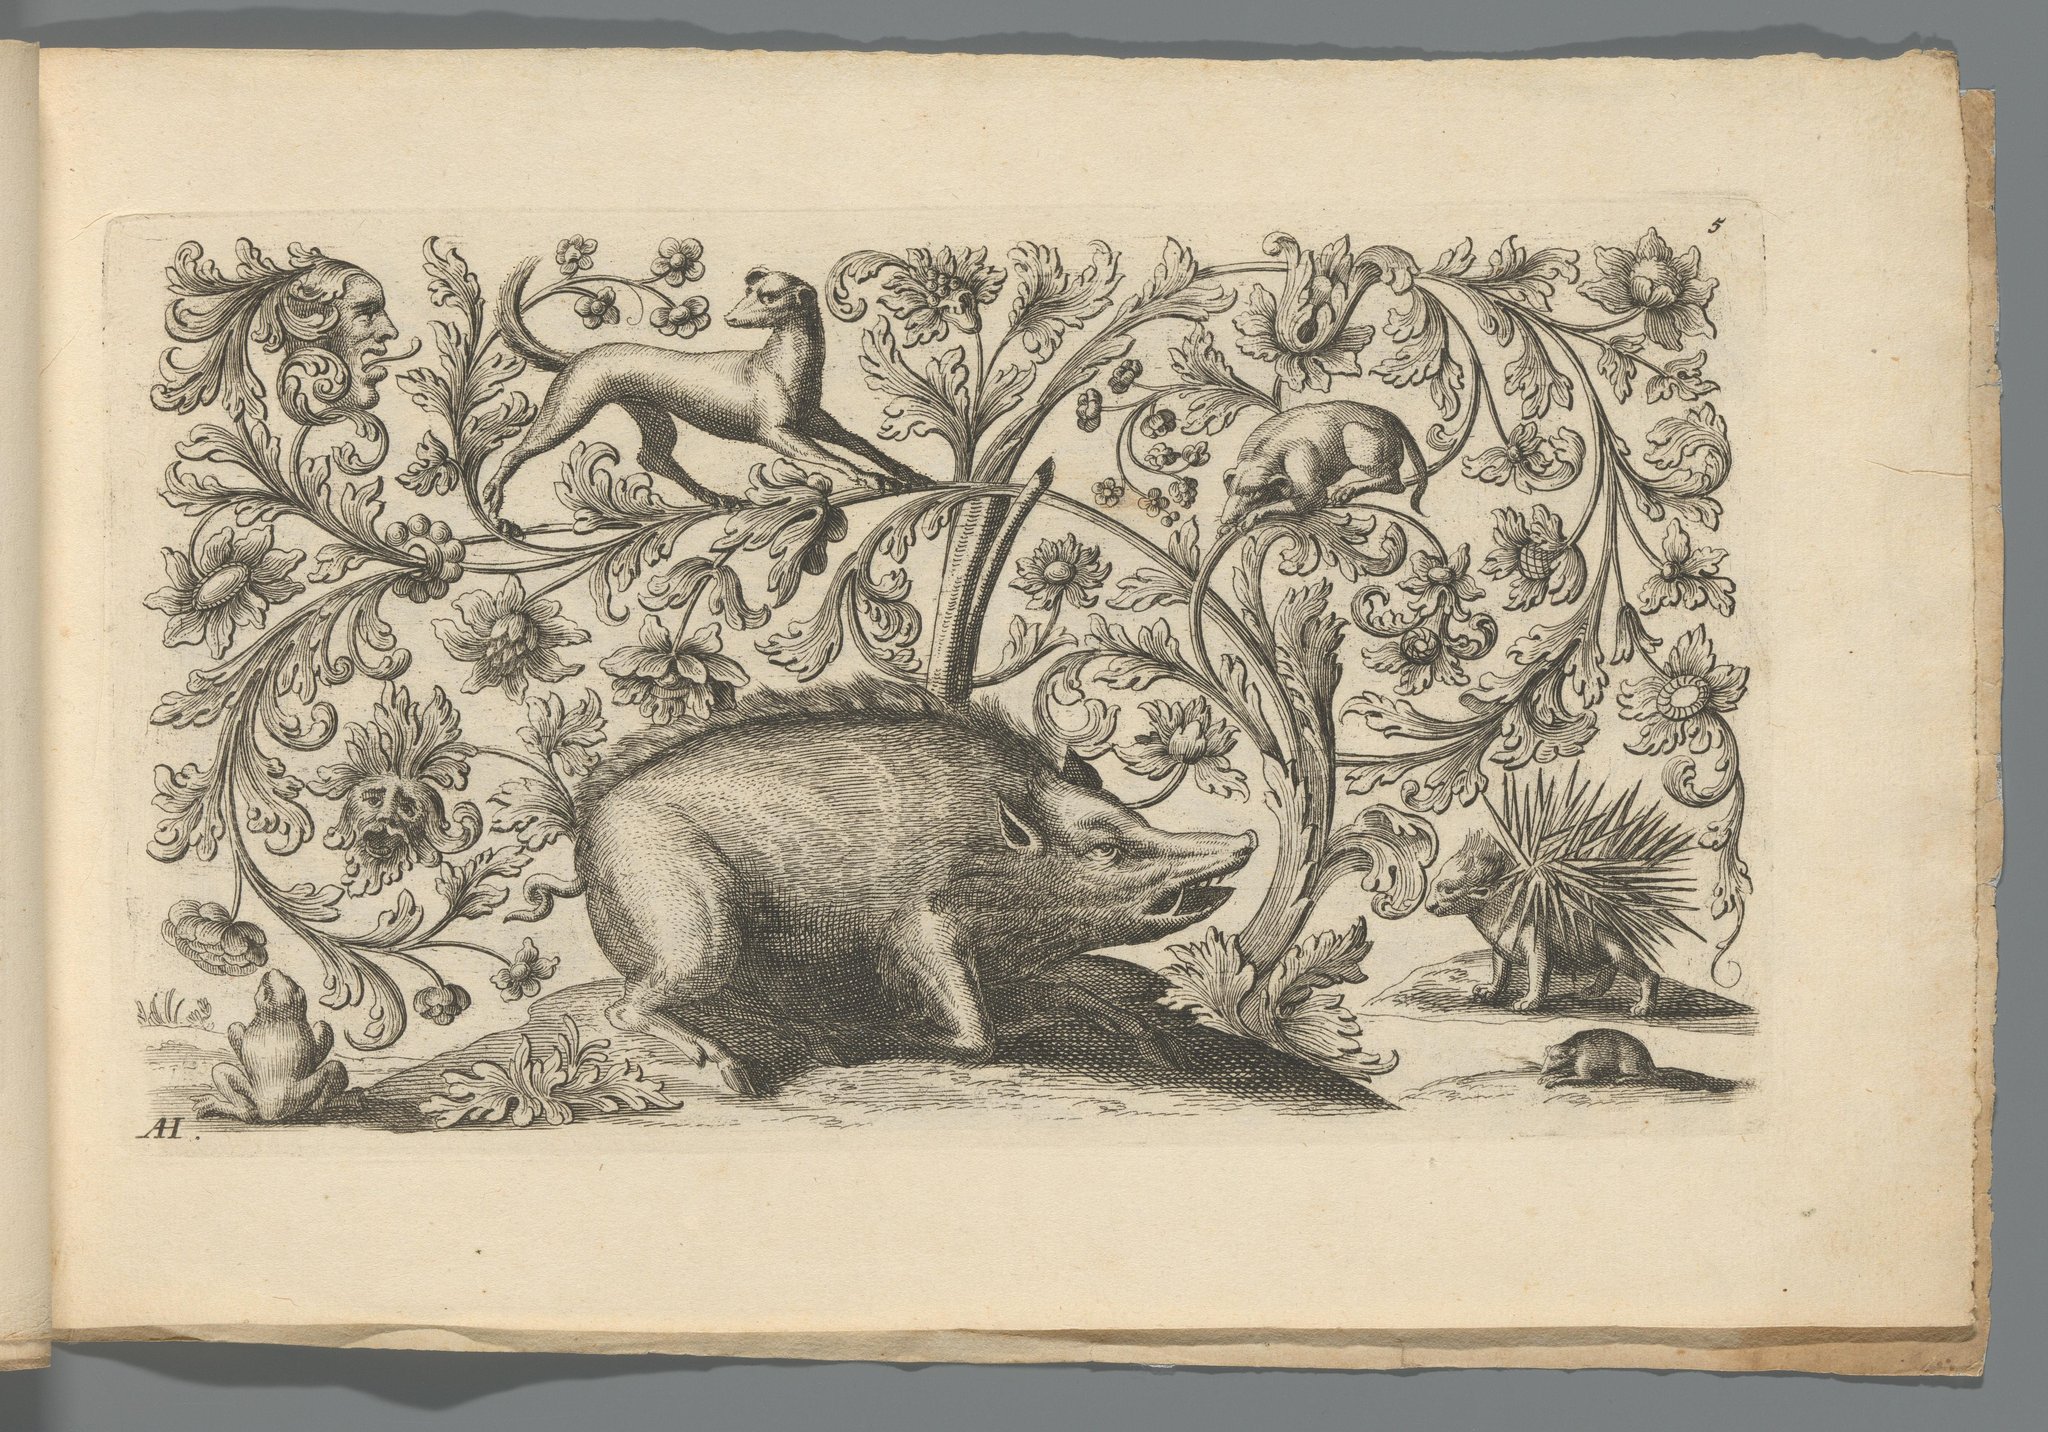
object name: print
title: Ornament met wild zwijn, honden, stekelvarken, kikker, muis en maskers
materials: paper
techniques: etching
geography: nuremberg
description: Wild zwijn, honden, stekelvarken, kikker, muis en maskers tussen ornamentele ranken met bloemen. Details zijn doorgeprikt.